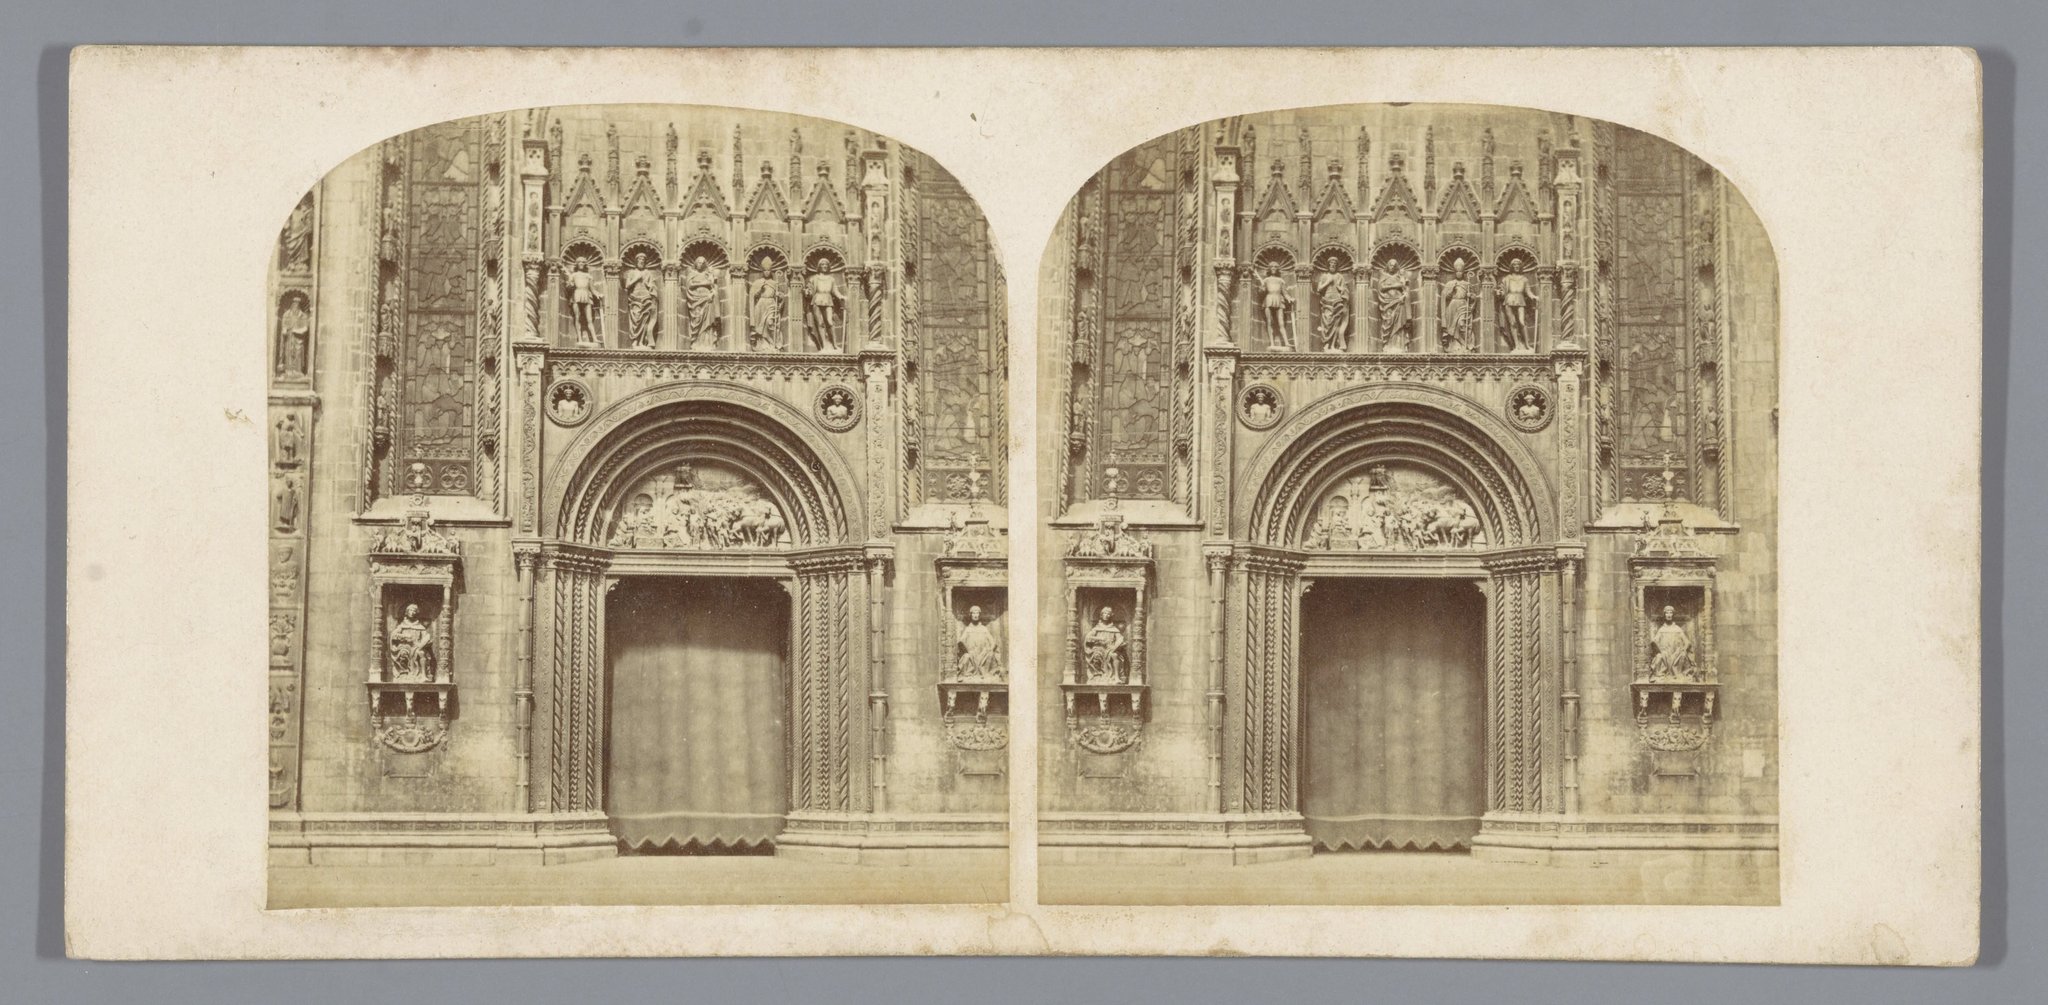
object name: stereograph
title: Portaal van de dom in Como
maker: Anonymous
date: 1860-1875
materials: cardboard, paper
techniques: albumen print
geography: como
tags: parts of church exterior and annexes: portal, parts of church exterior and annexes: west façade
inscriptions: annotation: ‘Porte du Dôme à/ Côme’